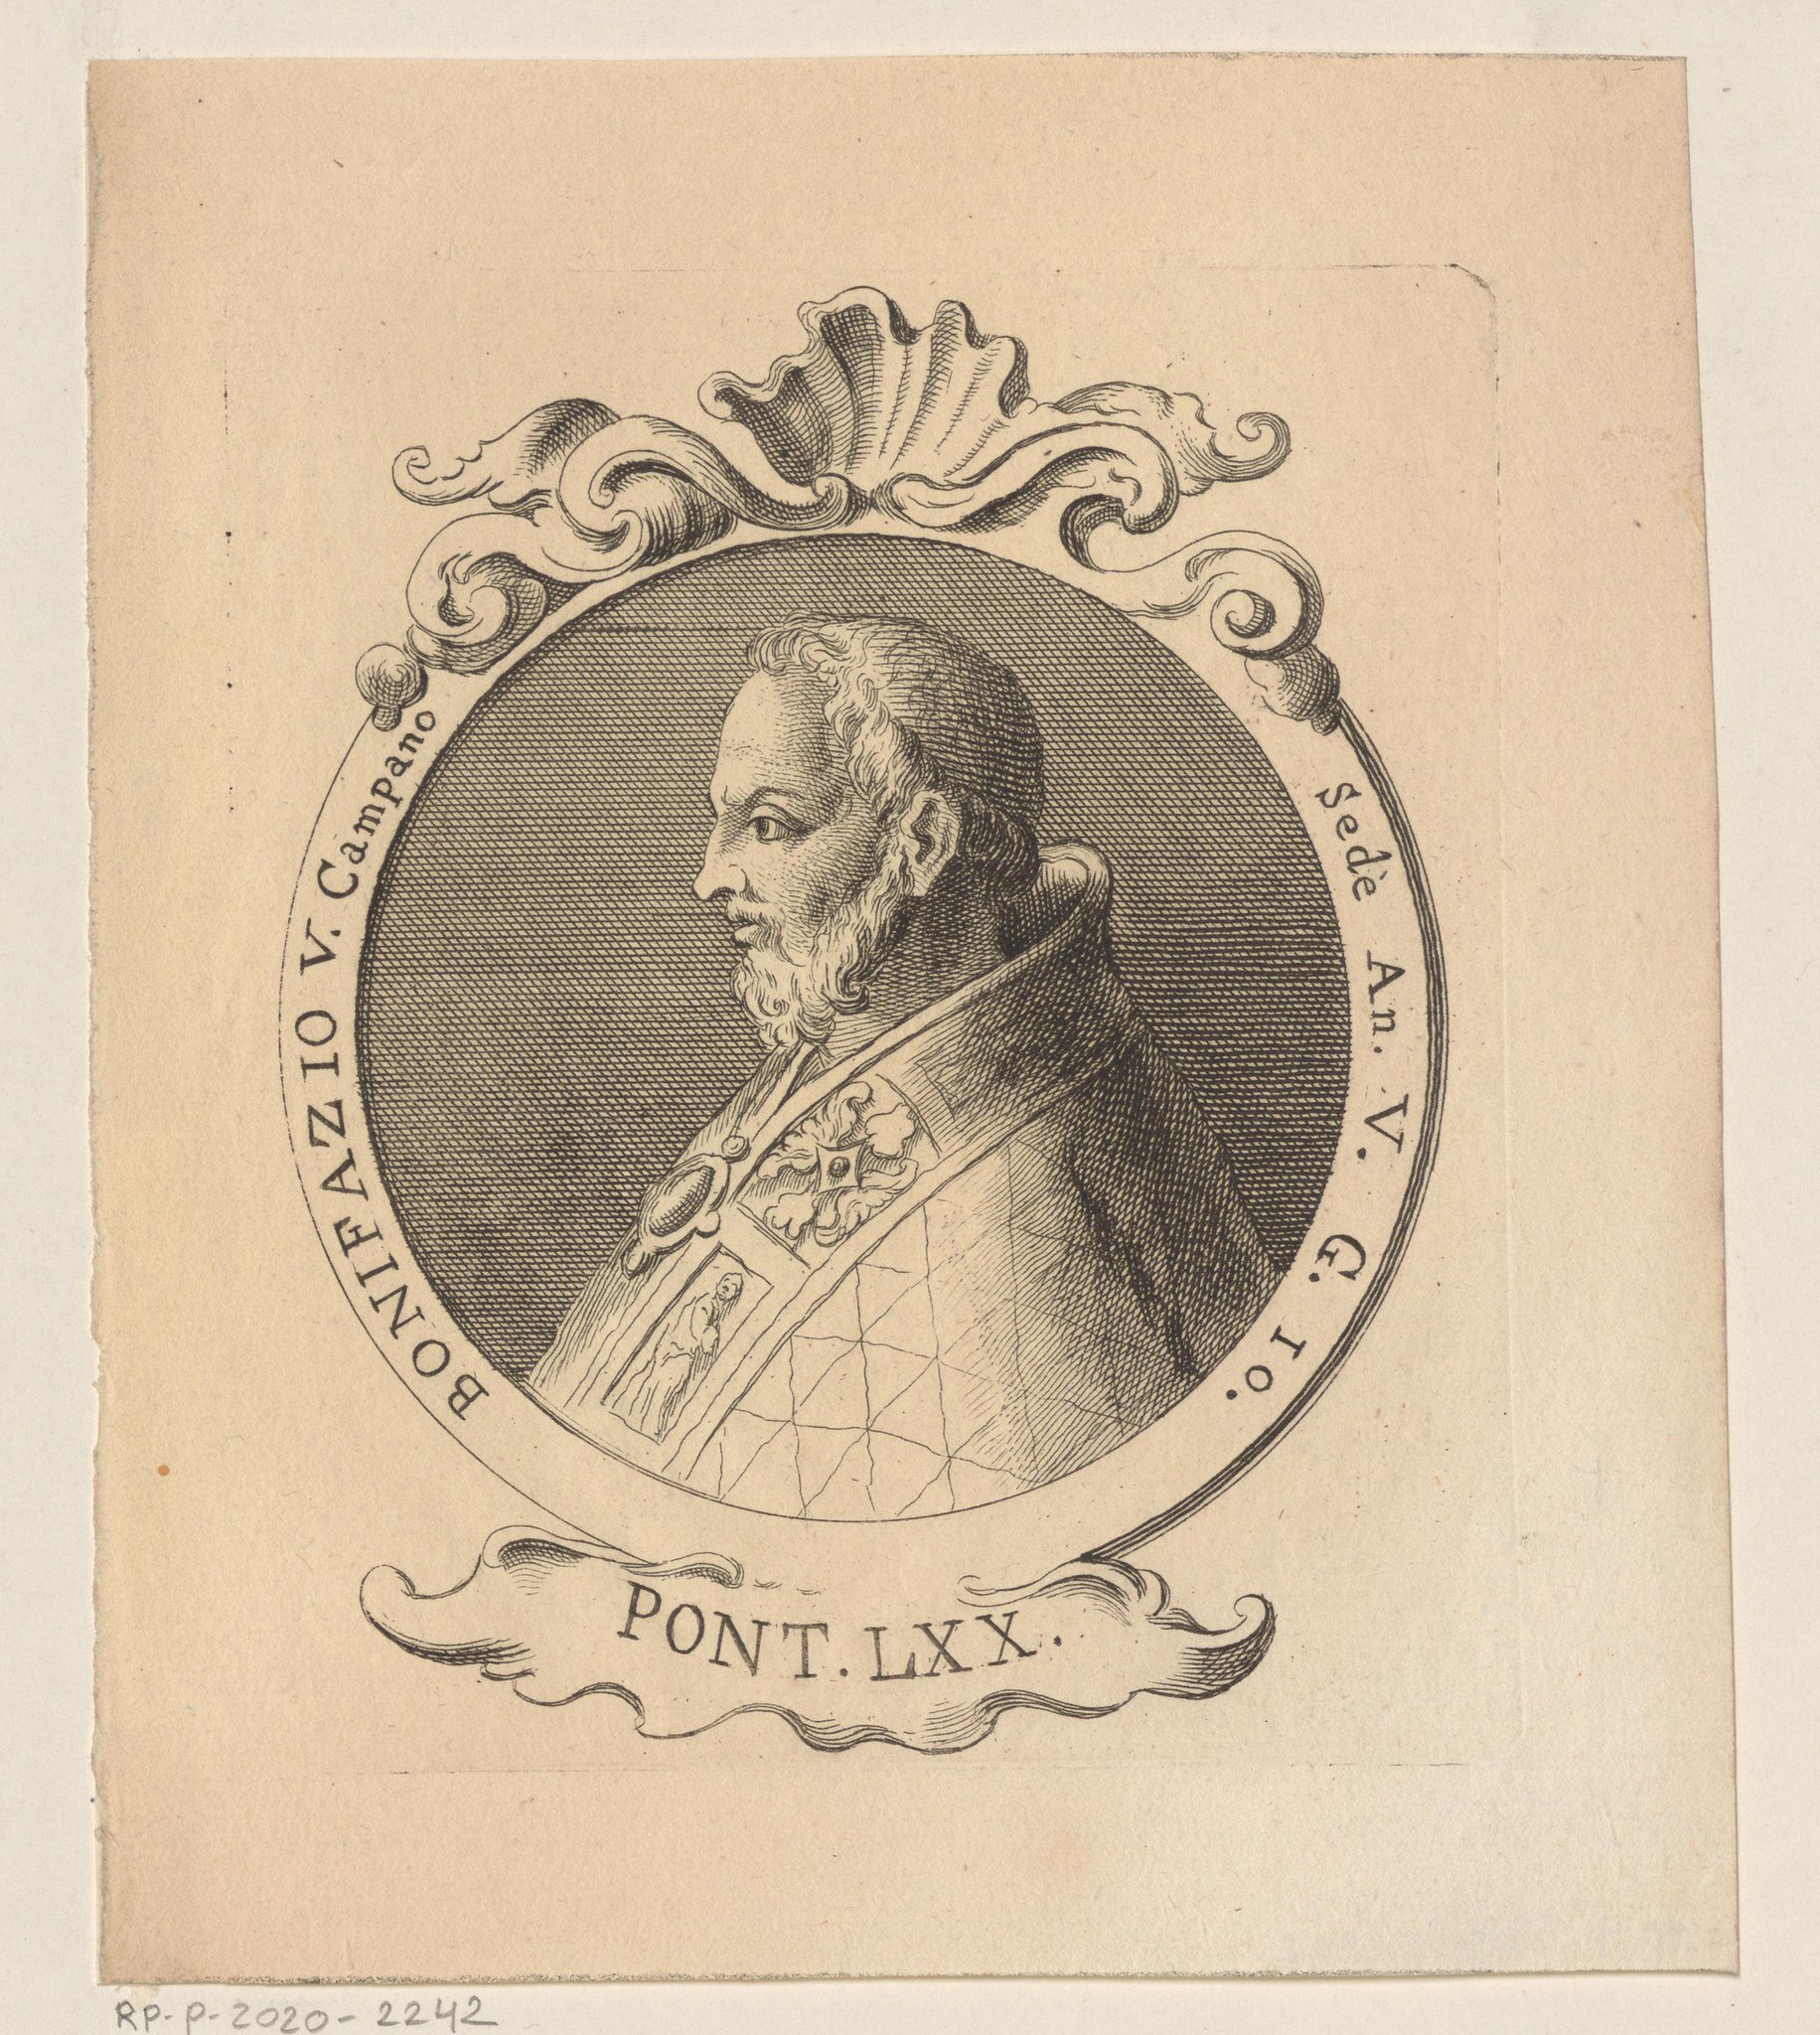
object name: book illustration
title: Portret van paus Bonifatius V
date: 1775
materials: paper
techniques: engraving, etching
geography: venice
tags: naples, historical persons, pope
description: Prent uit: Effigies Romanorum pontificum a S. Petro ad Pium VI. feliciter regnantem (...). 2 dln. Venetië en Bassano del Grappa: Giuseppe Remondini, 1775.